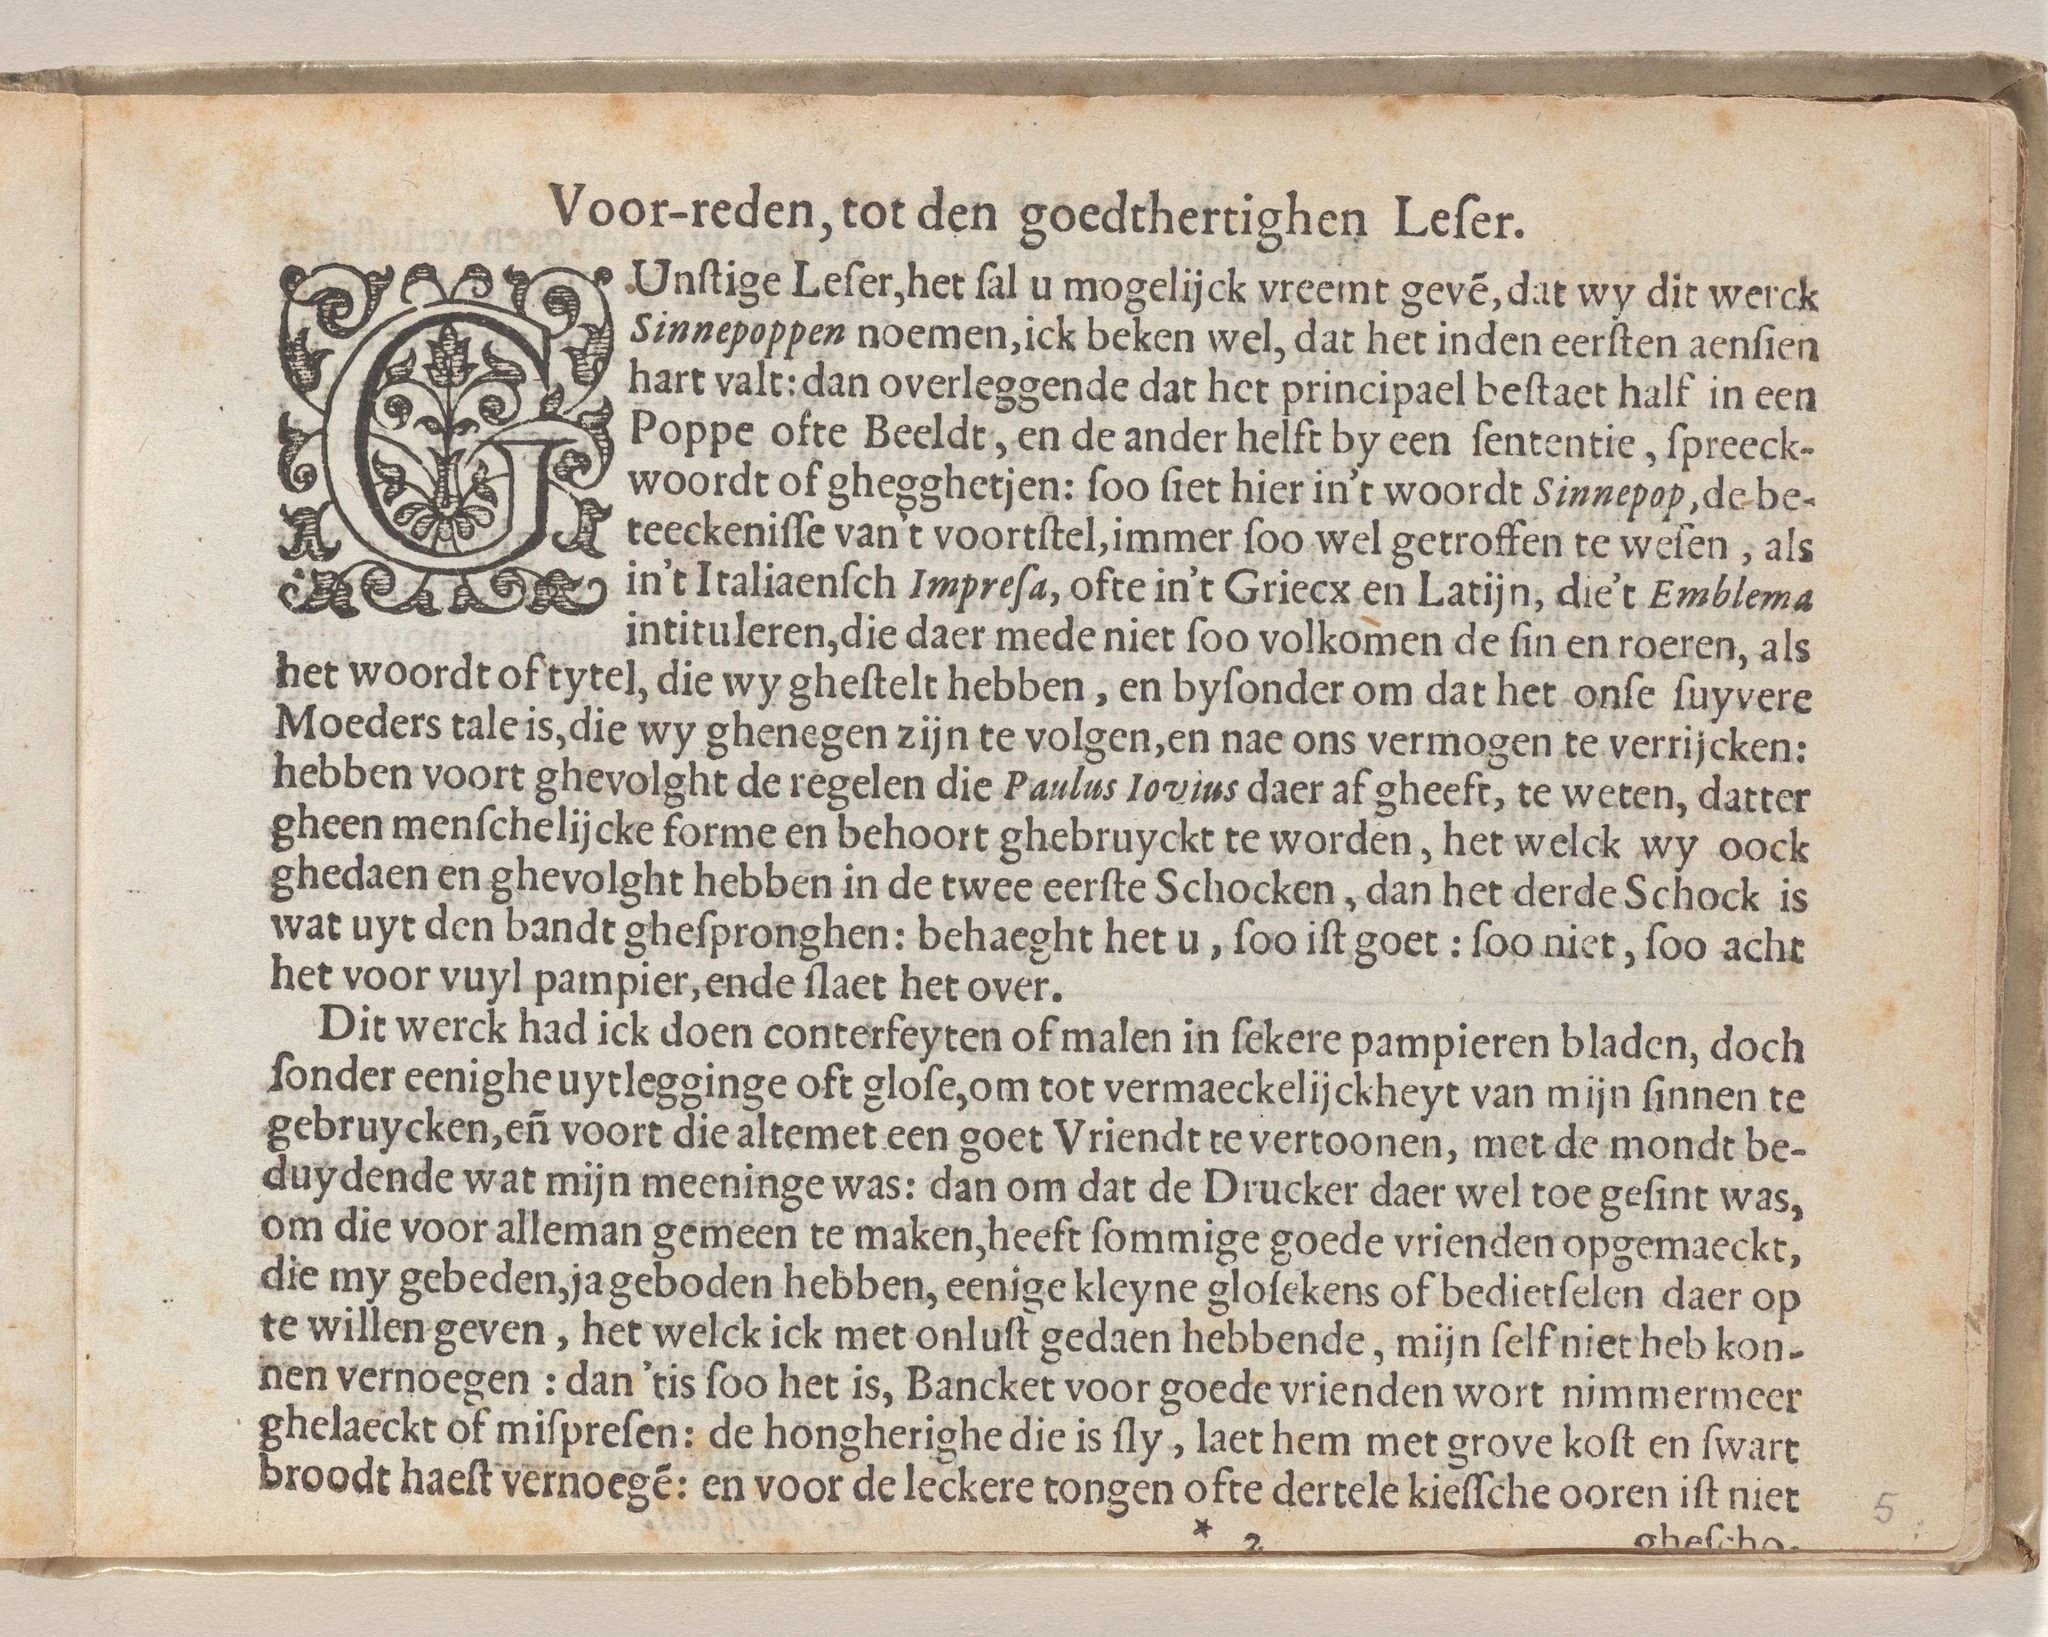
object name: album leaf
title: Voorrede tot de Sinnepoppen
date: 1614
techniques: engraving, printing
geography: amsterdam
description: Onderdeel van 'Sinnepoppen', R. Visscher, 1614.